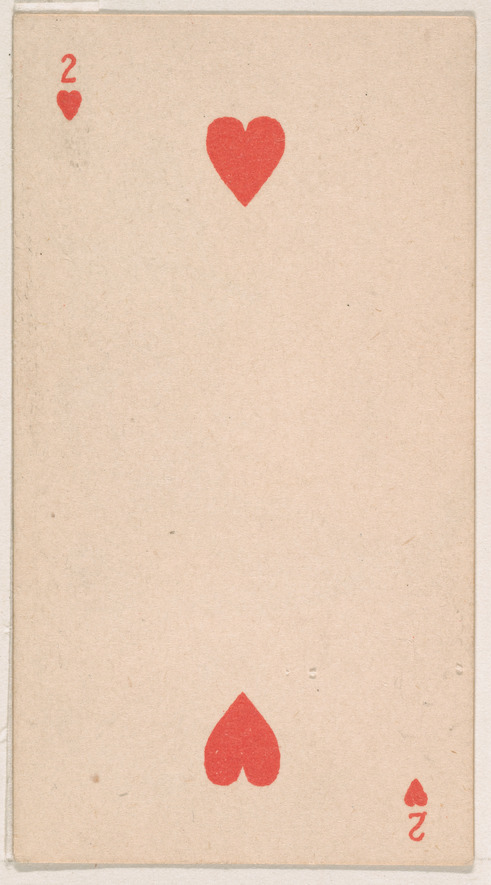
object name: print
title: Two of Hearts, from the Transparent Playing Cards series (N220) issued by Kinney Bros.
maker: kinney brothers tobacco company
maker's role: publisher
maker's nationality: american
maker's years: 1869-2011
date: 1888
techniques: color lithograph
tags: playing cards